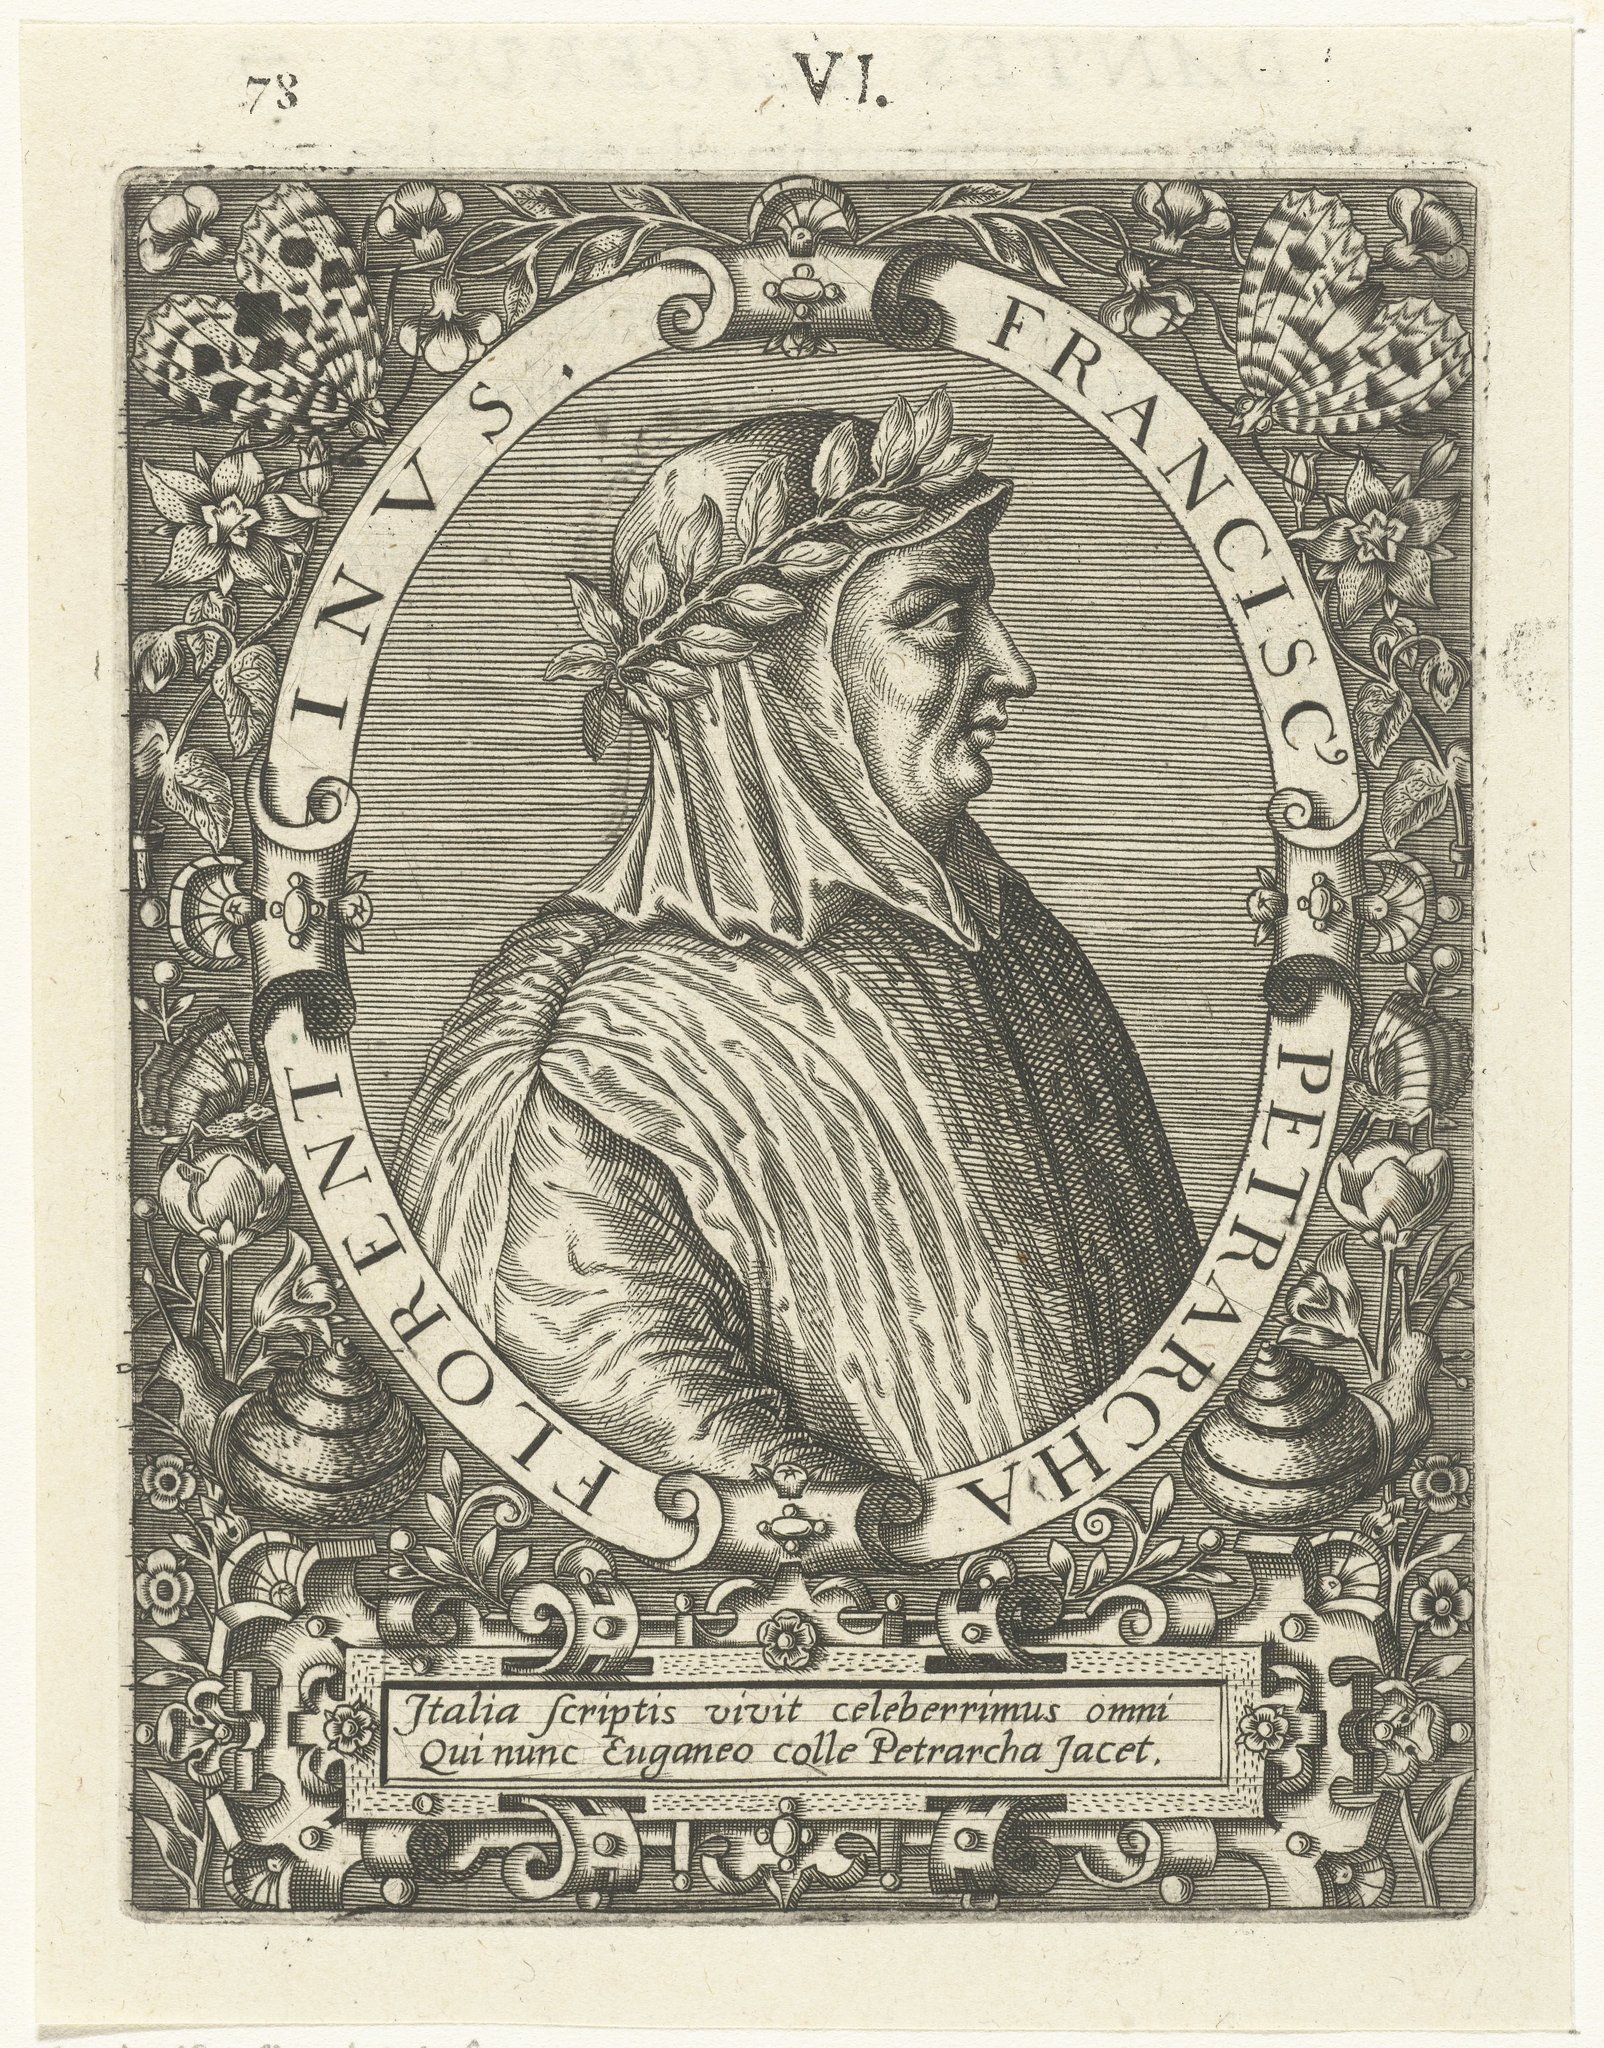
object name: print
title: Portret van Francesco Petrarca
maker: jean jacques boissard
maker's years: 1528-1598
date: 1597-1599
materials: paper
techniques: engraving, letterpress printing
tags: francesco petrarca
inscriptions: collector's mark: Lugt 2228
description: Gemaakt voor: J.J. Boissard, Icones virorum illustrium doctrina &c eruditione praestanti um contines. Frankfurt am Main: de Bry, 1597-1599.